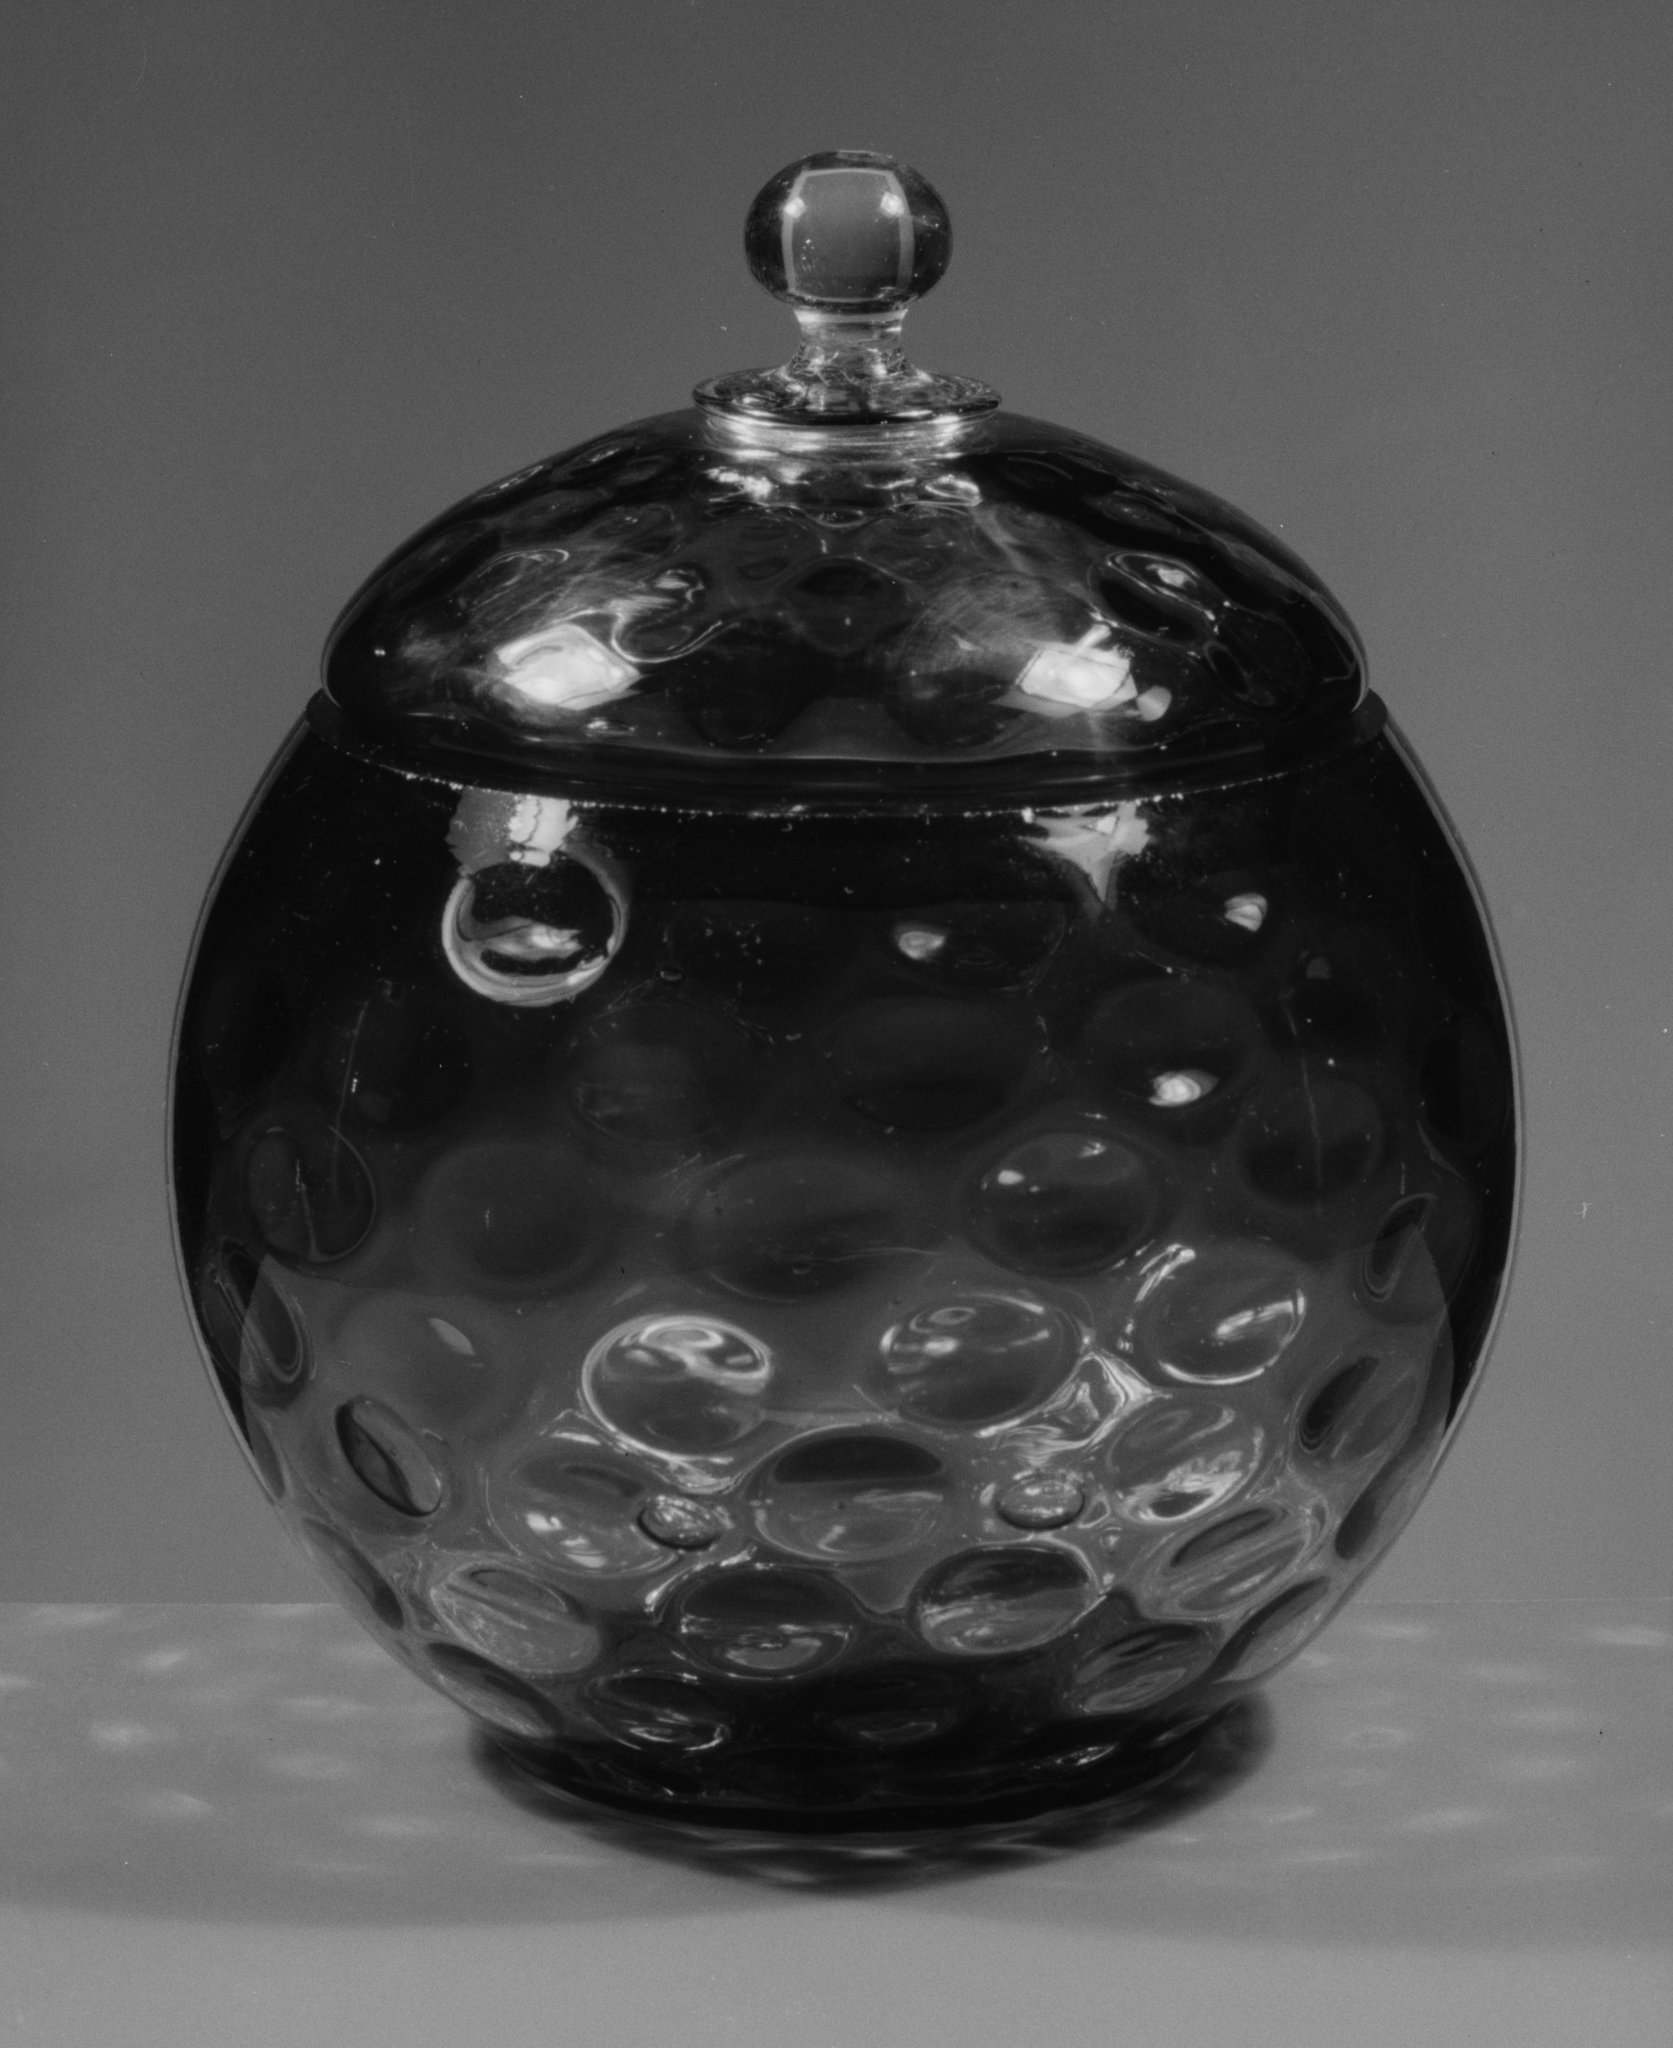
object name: bowl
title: Covered Bowl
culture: american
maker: hobbs, brockunier and company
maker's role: maker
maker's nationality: american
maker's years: 1863-1891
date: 1885-1887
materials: glass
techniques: glassblowing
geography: united states